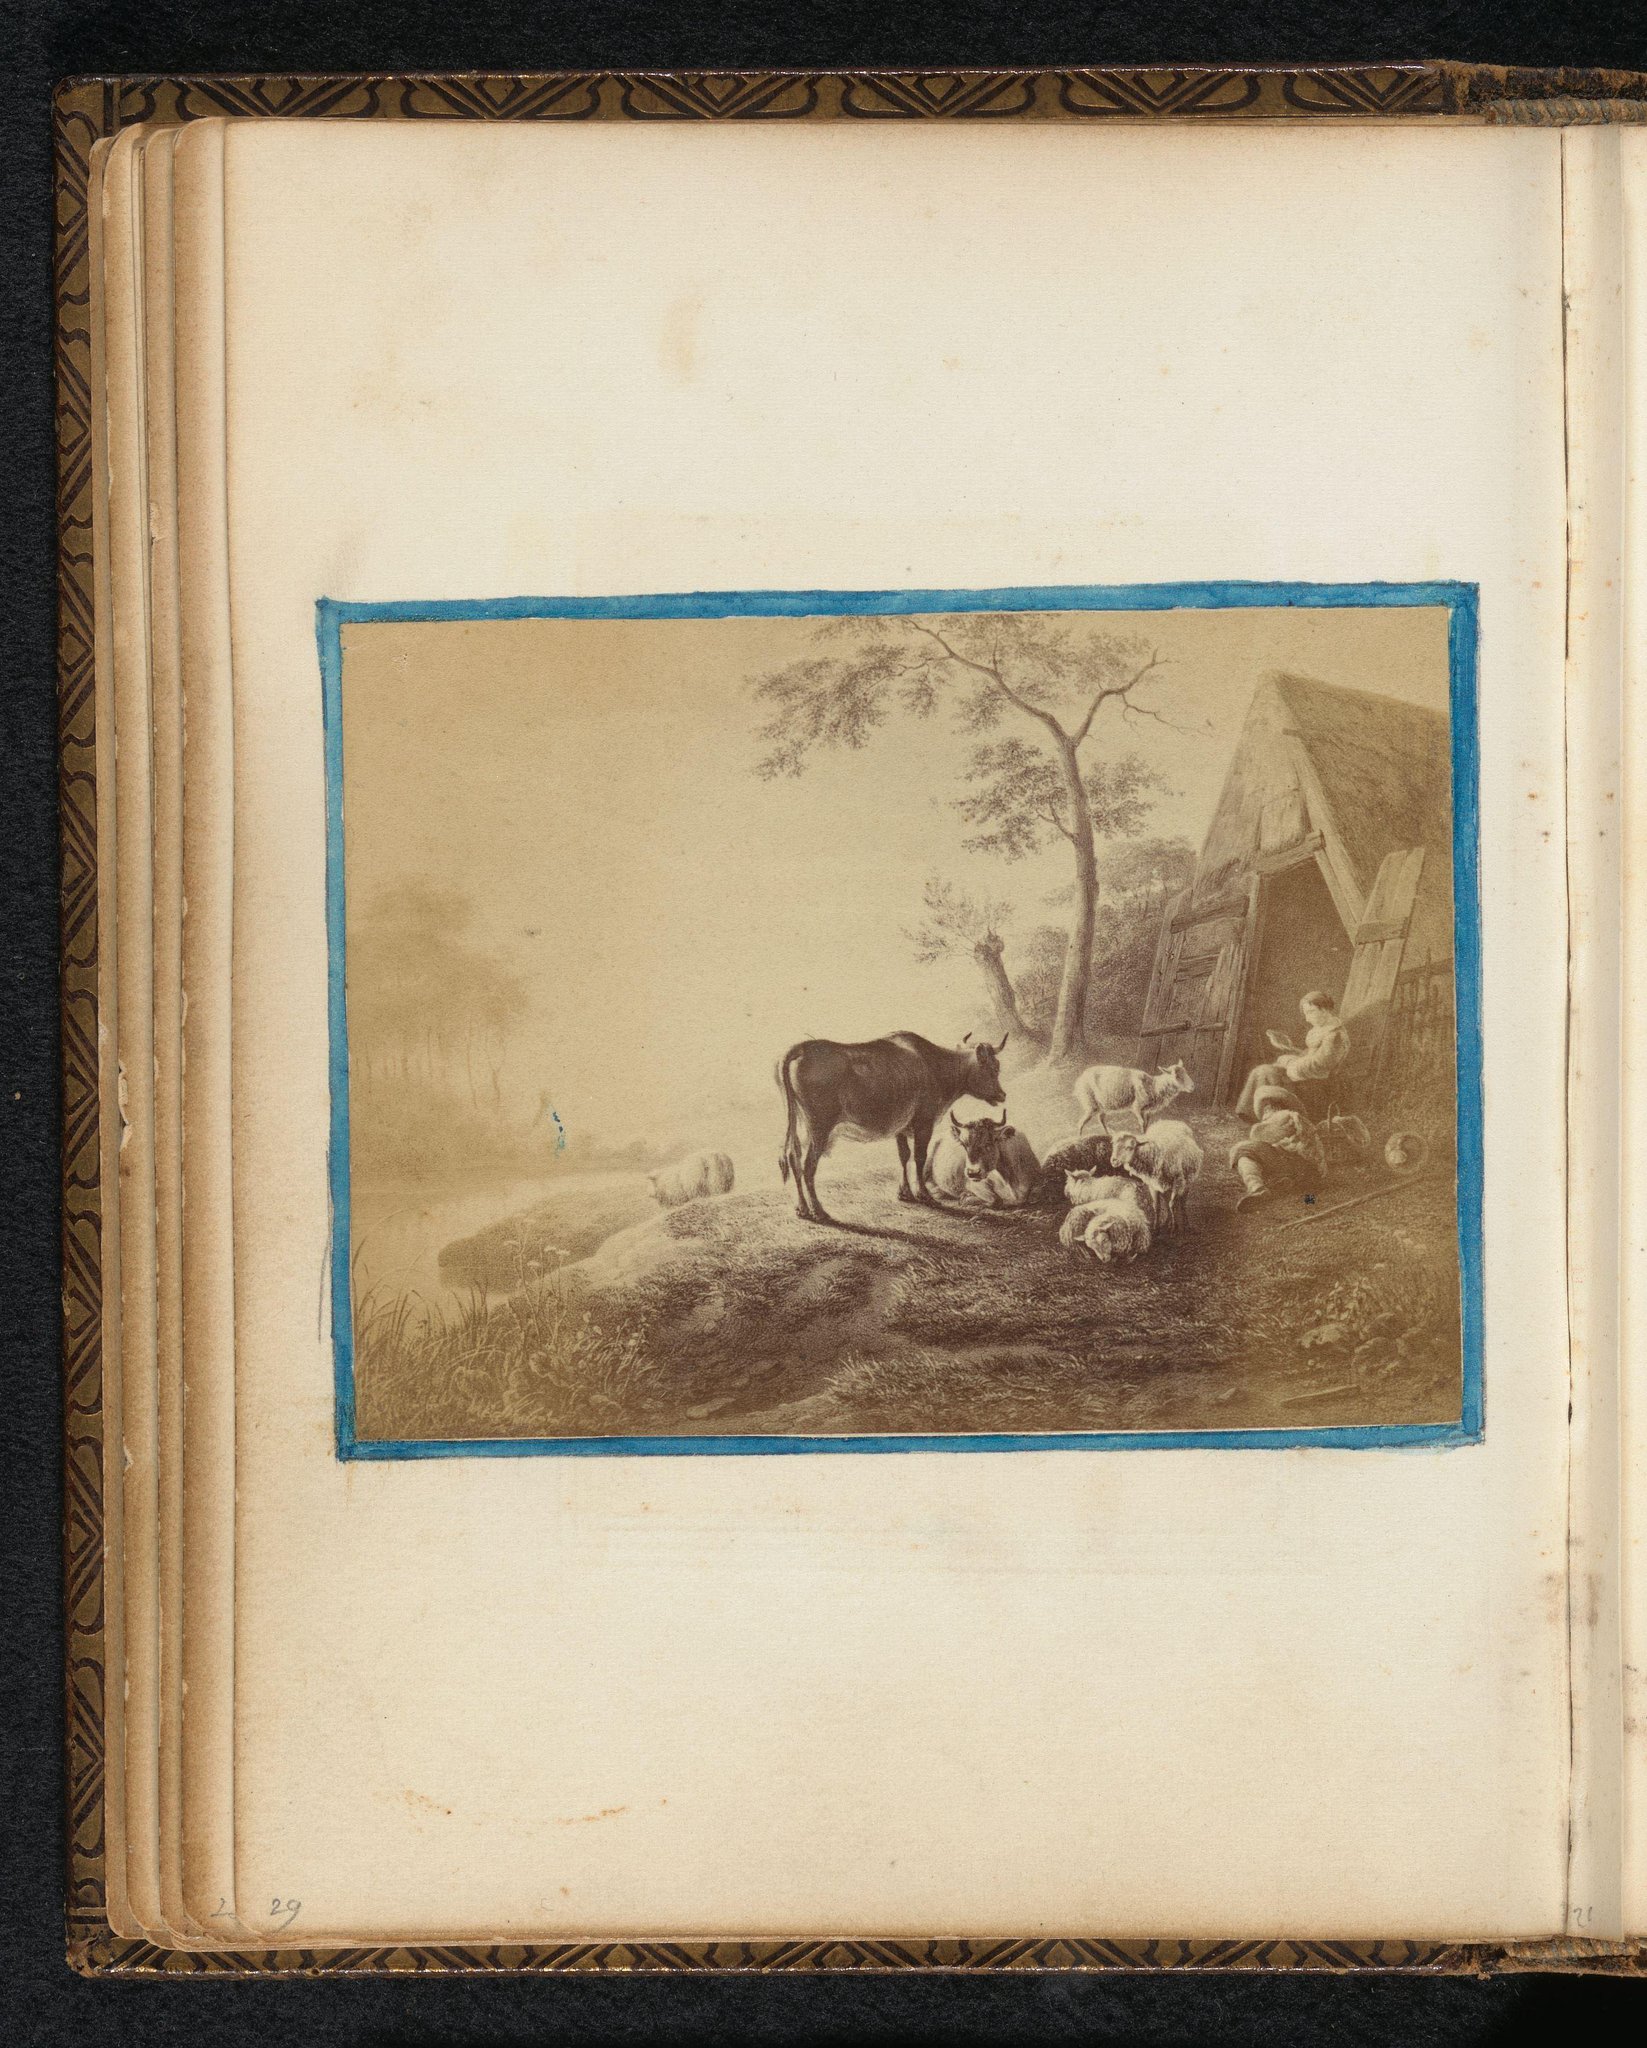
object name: album leaf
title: Schilderij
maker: Anonymous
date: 1865-1867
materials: cardboard, photographic support, watercolor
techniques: albumen print, aquarelle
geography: england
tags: picture, painting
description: Schilderij met vee. Foto op albumblad in album met 68 foto's merendeels met geaquarelleerde randversieringen. Het zijn voornamelijk portretten op carte-de-visite formaat.